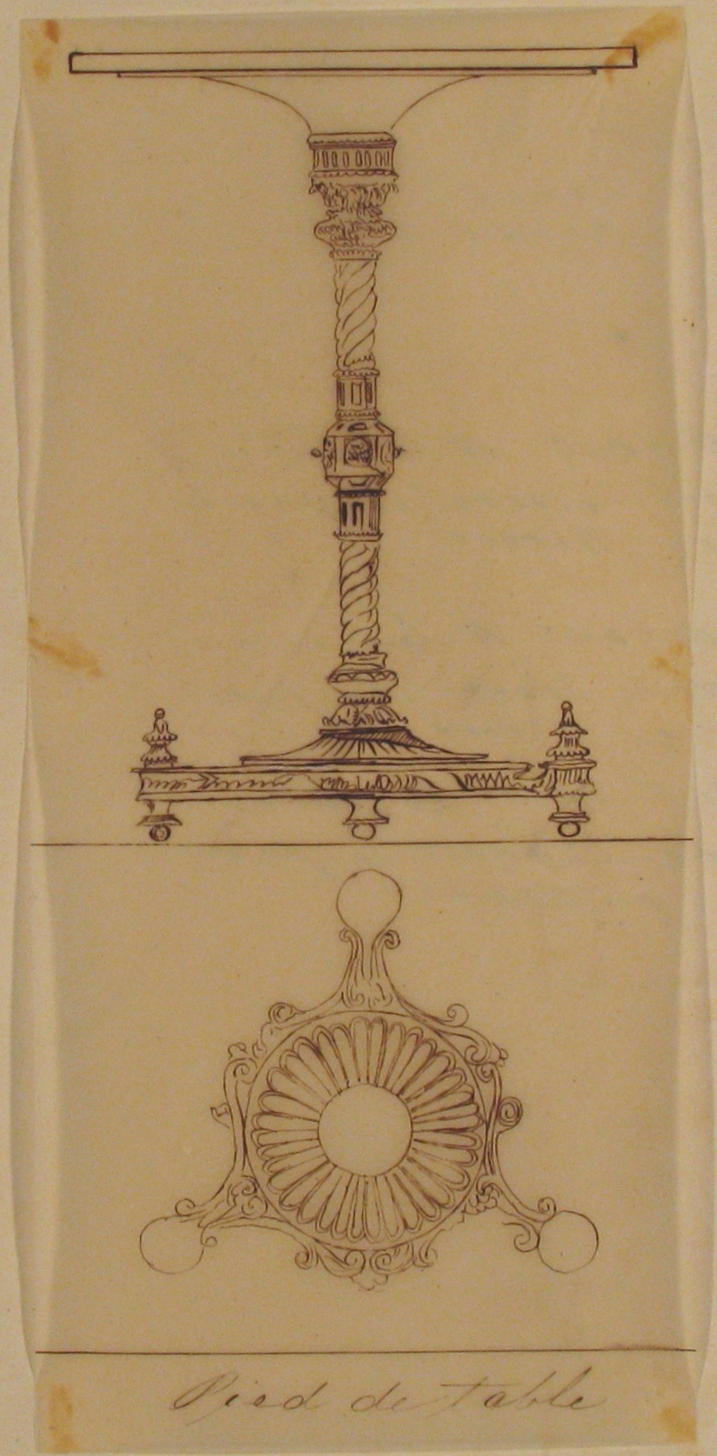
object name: drawing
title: Designs for a Table and a Table Base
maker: anonymous, french, 19th century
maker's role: artist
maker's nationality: french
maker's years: 1800-1900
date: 1801-1900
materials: ink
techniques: pen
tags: tables